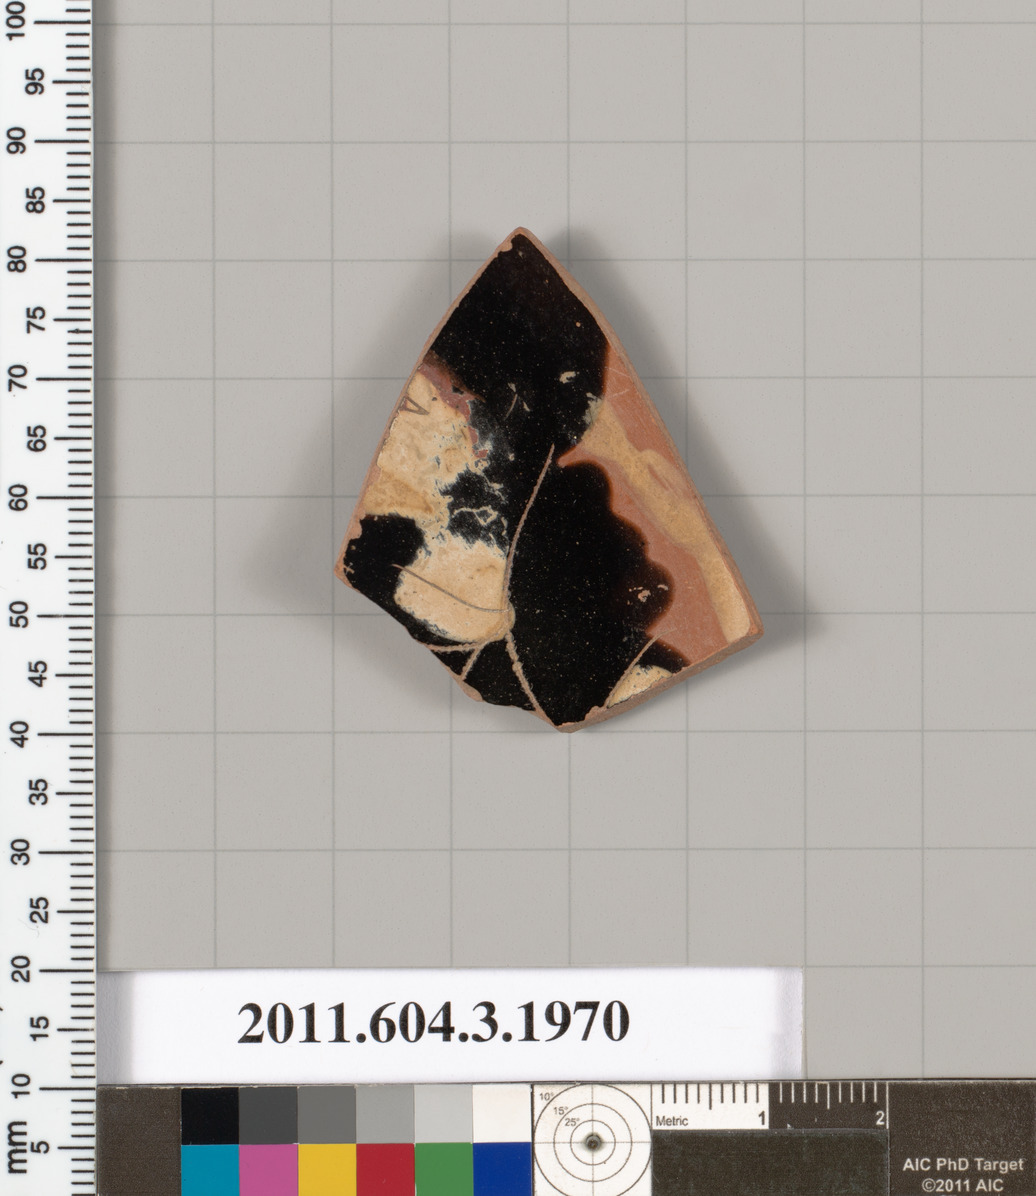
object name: kylix fragment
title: Terracotta fragment of a kylix (drinking cup)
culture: greek, attic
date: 550-526 BCE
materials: terracotta